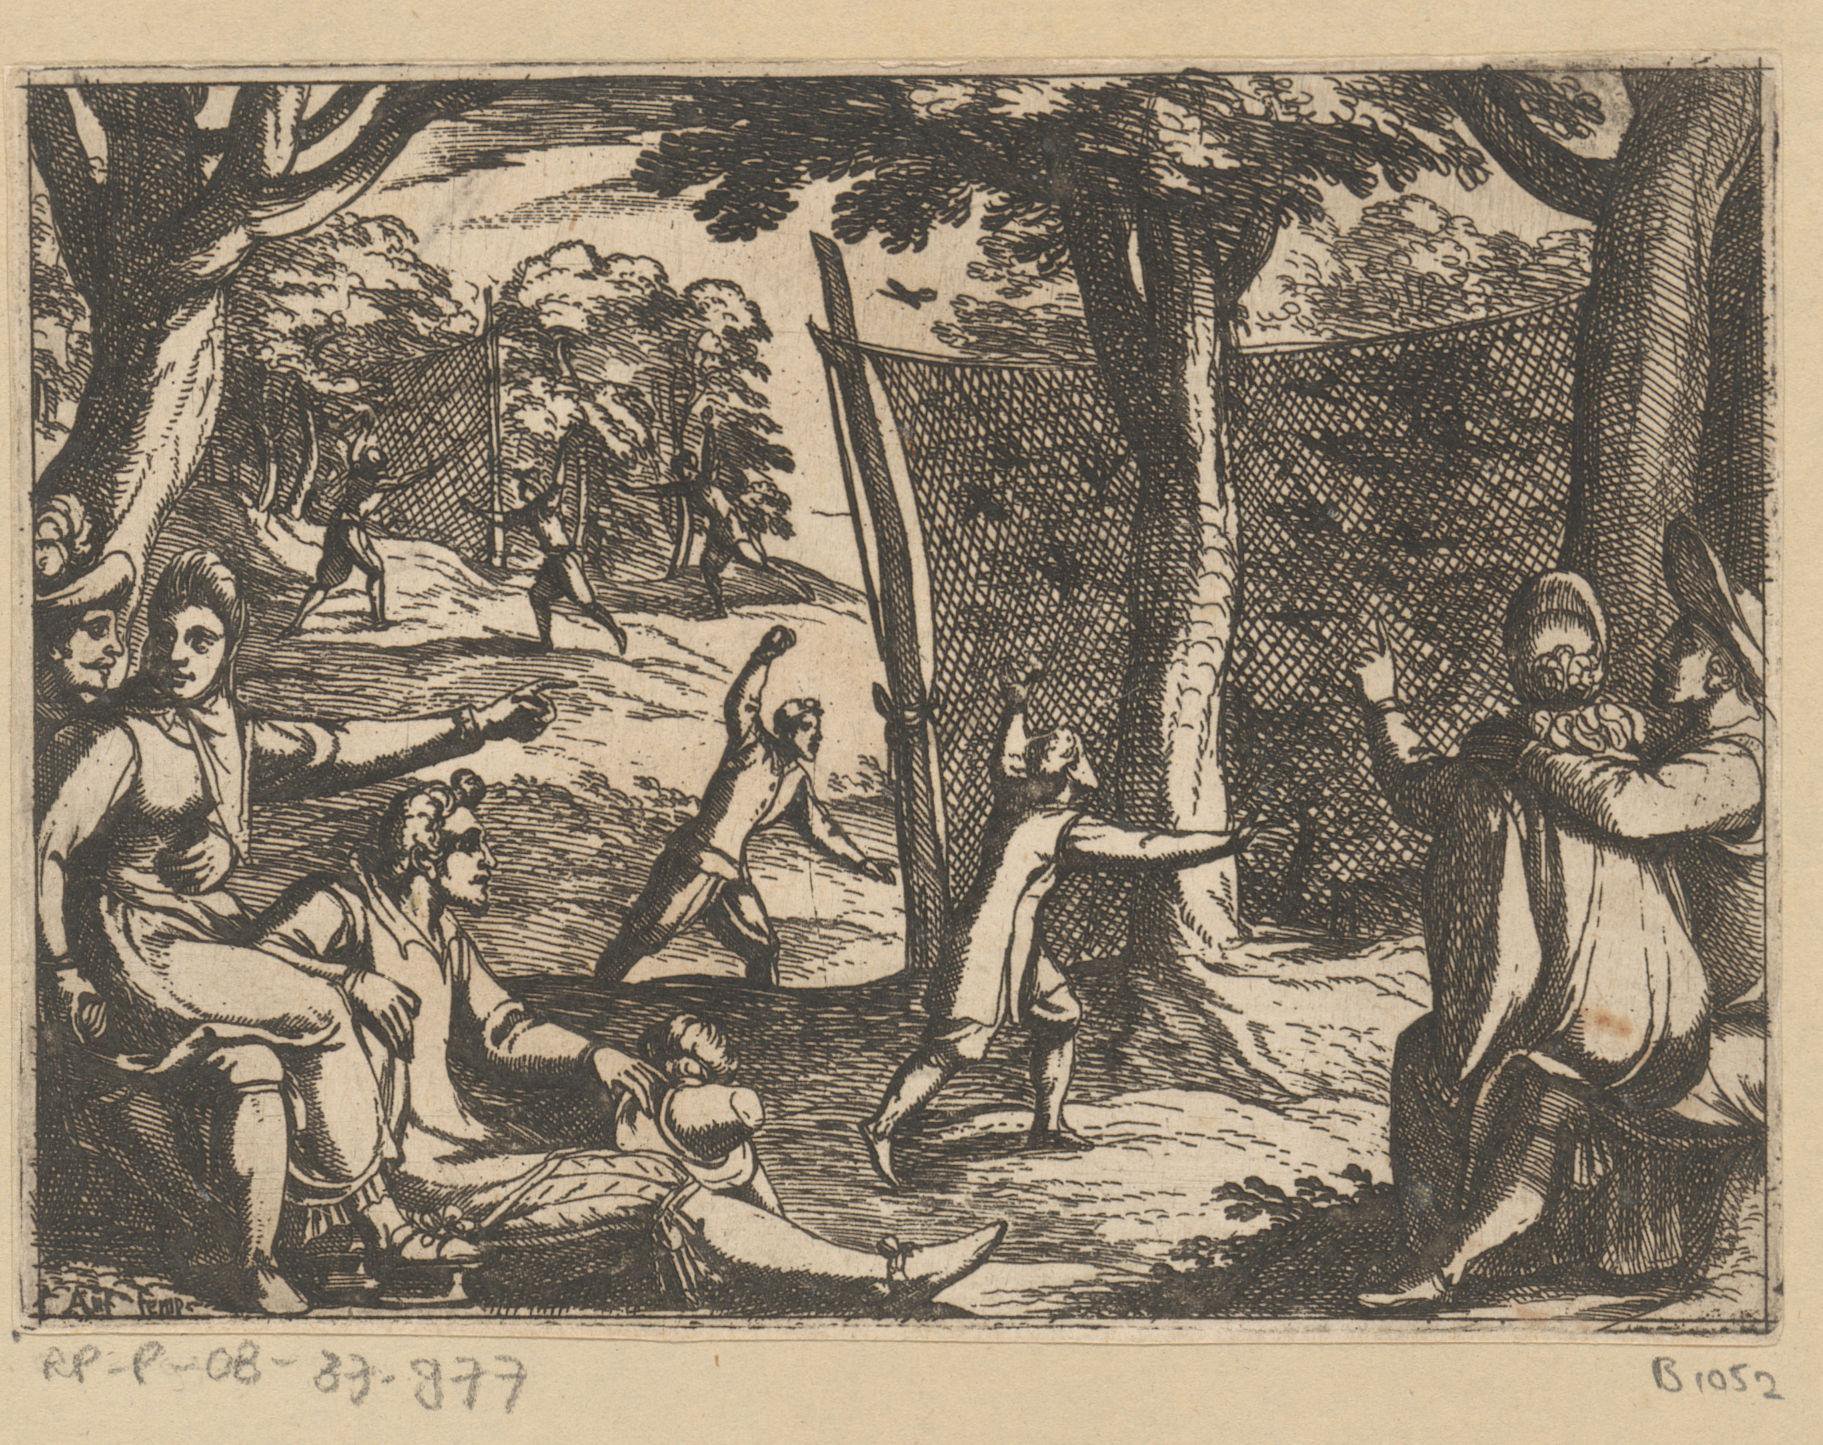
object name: print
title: Primo libro di caccie varie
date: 1598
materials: paper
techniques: etching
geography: italy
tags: hunter, hunters hunting (n.b.: in 1988-1990 this notation denoted the concept of 43c11421 'hunters resting during the hunt'), bird hunting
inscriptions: collector's mark: Lugt 240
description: Landschap met jagers die grote netten hebben gespannen om vogels mee te vangen. Op de voorgrond links en rechts jagers die rusten met hun vrouwen.